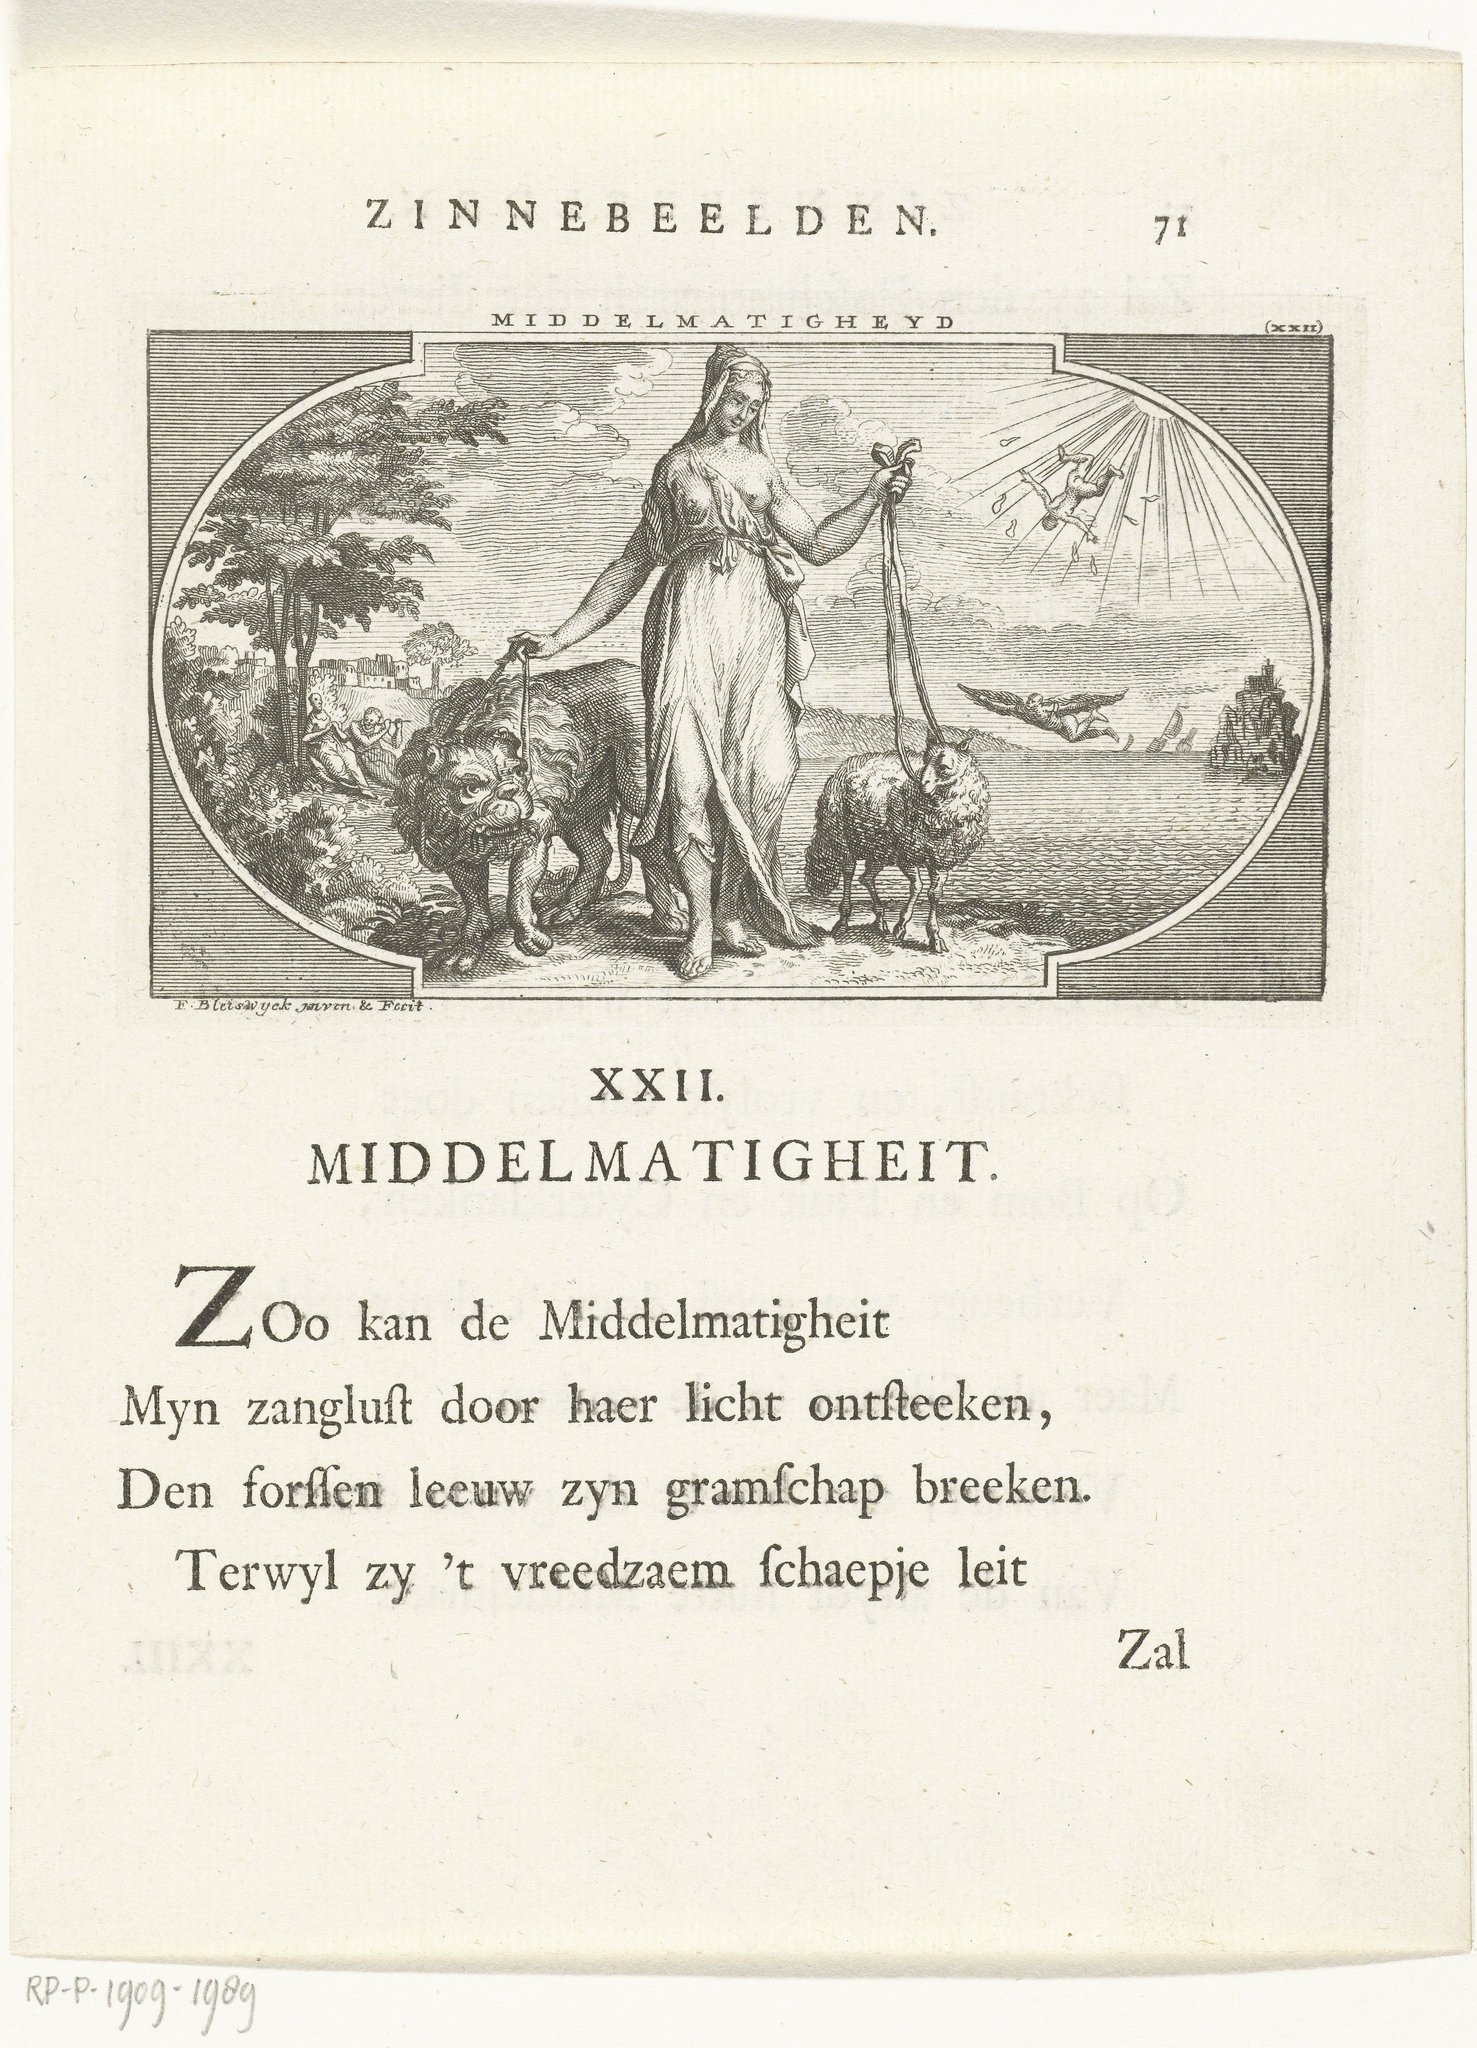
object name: book illustration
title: Embleem met allegorie op bedachtzaamheid (middelmatigheid)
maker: françois van bleyswijck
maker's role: draughtsman, print maker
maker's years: 1671-1746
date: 1681-1737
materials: paper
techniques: etching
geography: leiden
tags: forethought, deliberation; 'previdenza', 'providenza' (ripa)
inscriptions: collector's mark: Lugt 2228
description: Embleem met allegorie op bedachtzaamheid of ingetogenheid, in de titel met verouderde term middelmatigheid aangeduid. Verbeeld als vrouw houdt zowel lam als leeuw aan een teugel in toom. In het landschap achter haar zien we Icarus in problemen, de was in zijn vleugels smelt door de warmte van de zon en hij stort neer, geen weloverwogen handeling. Onder de voortelling staat een gedicht dat op het verso wordt vervolgd.